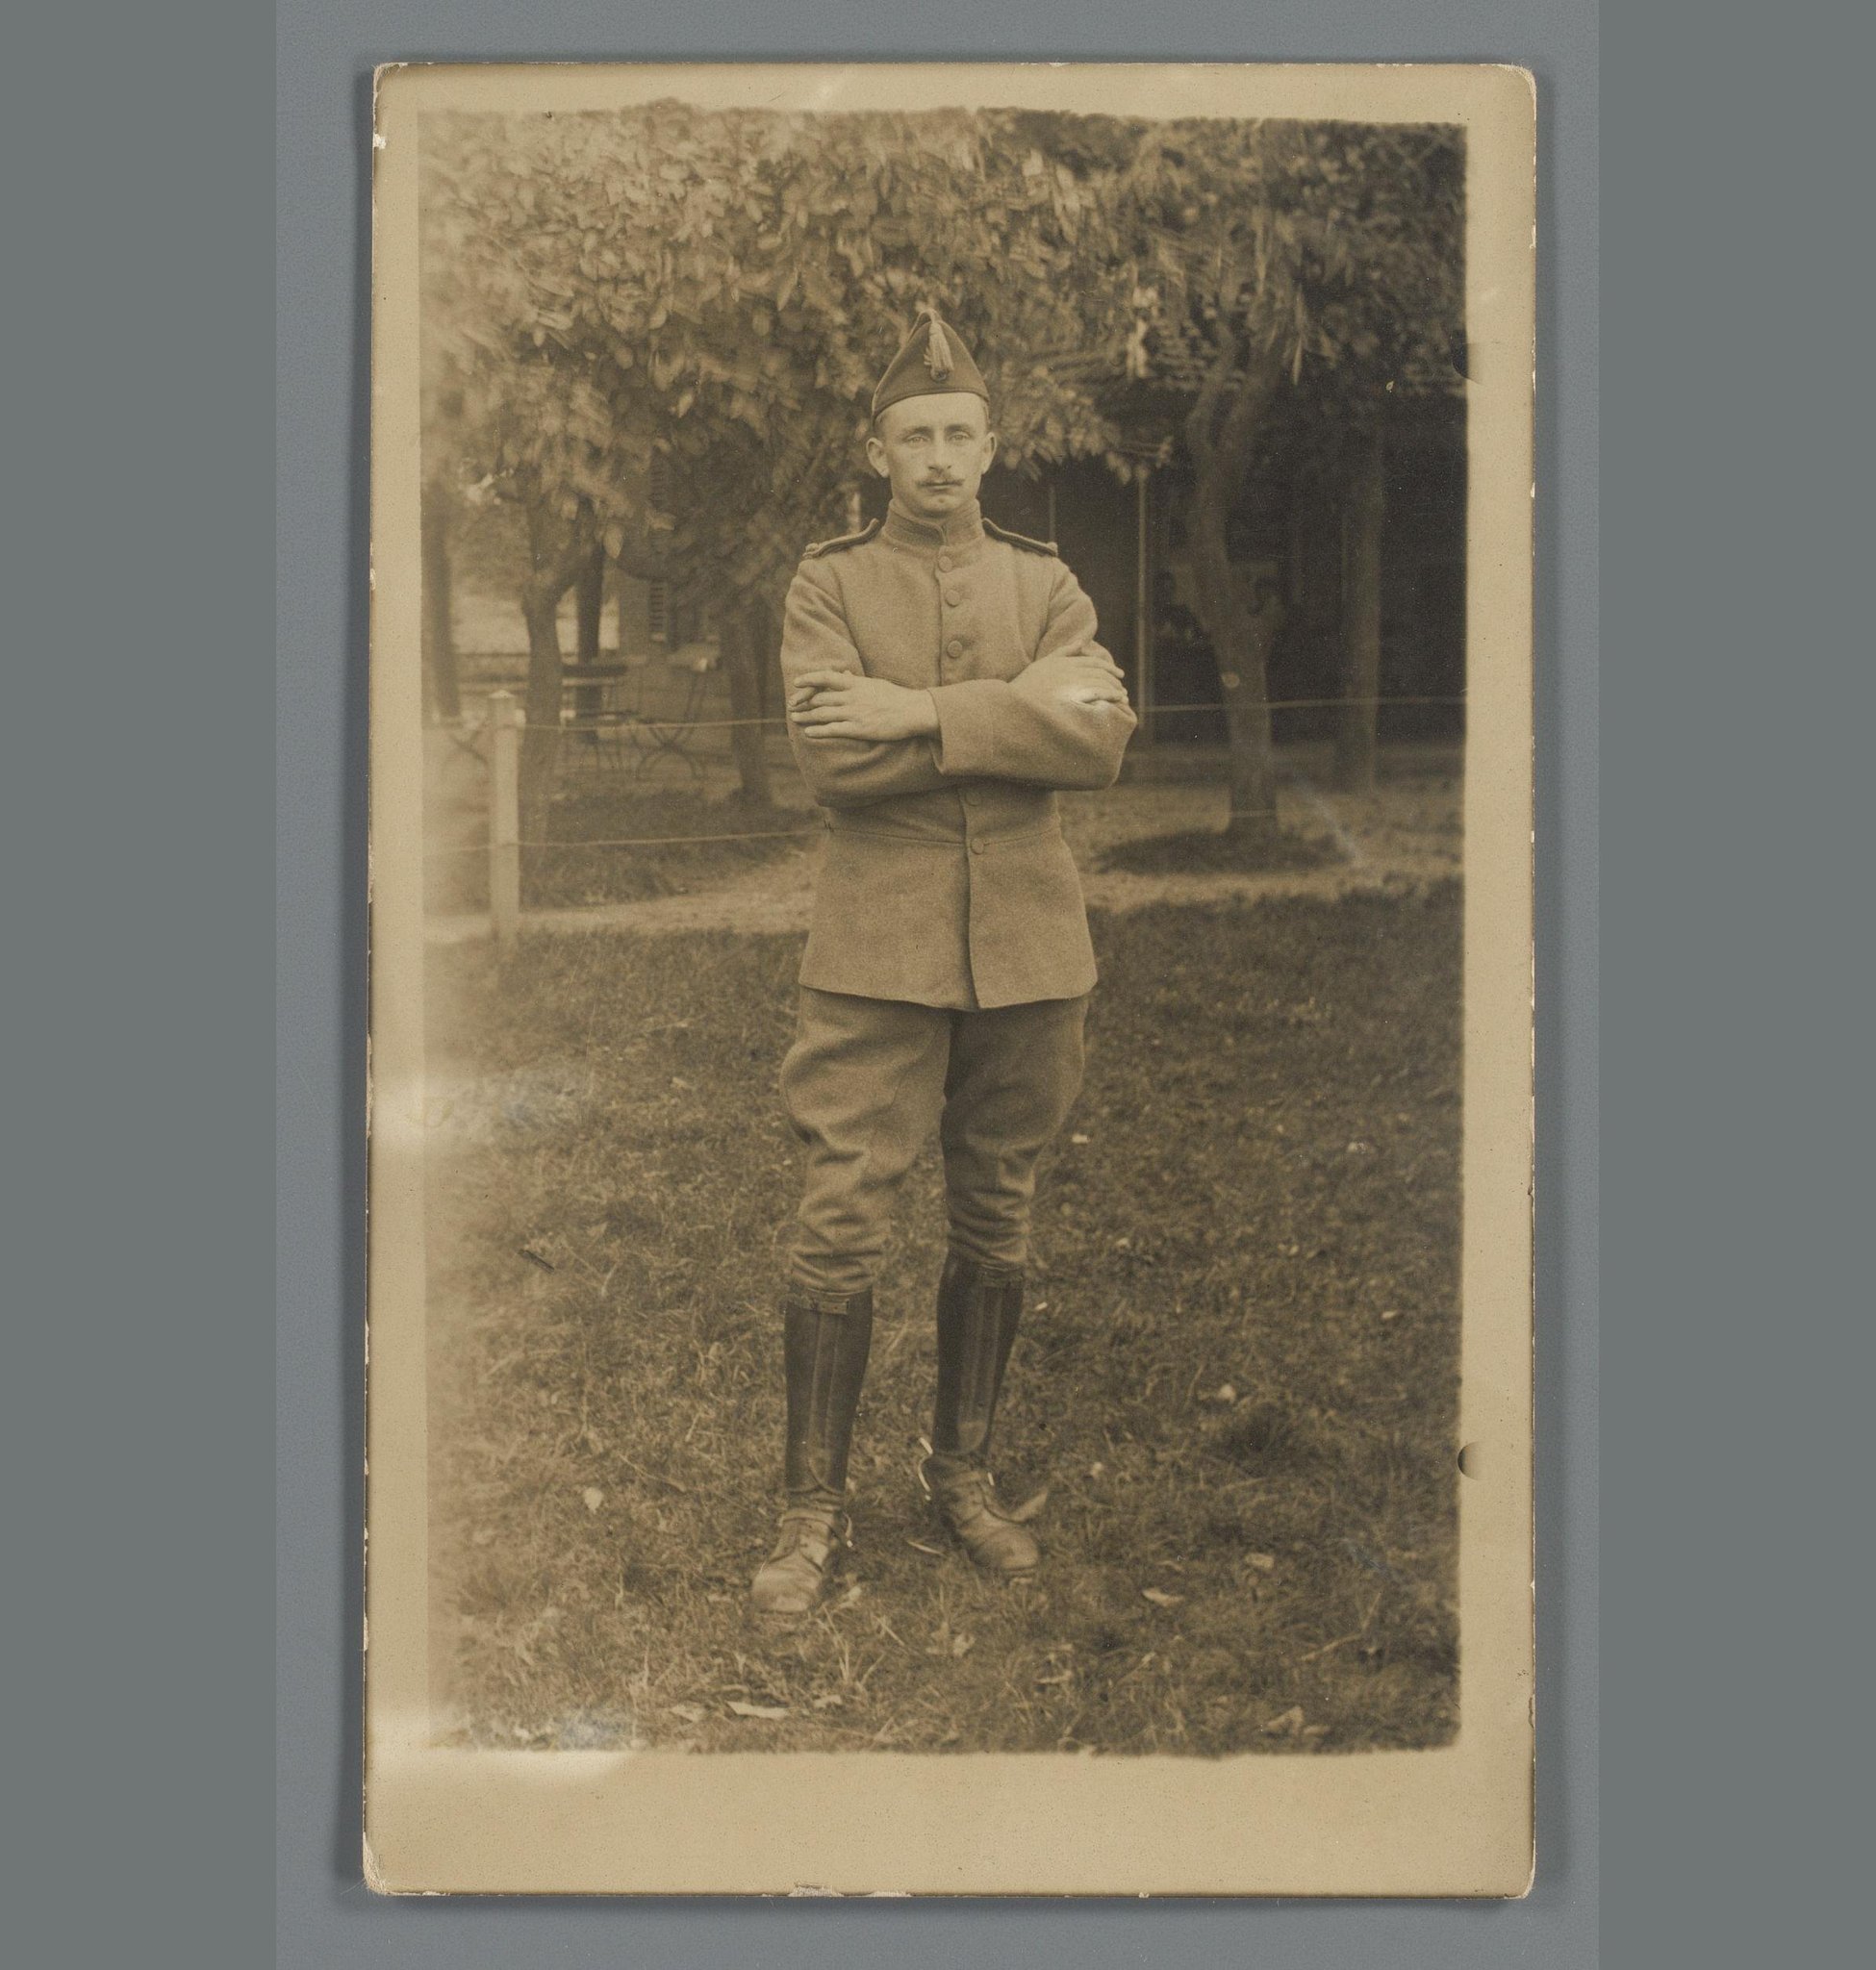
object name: photograph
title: Portret van een onbekende man in militair uniform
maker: Anonymous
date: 1905-1920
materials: paper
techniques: gelatin silver print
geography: netherlands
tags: (military) uniforms, historical persons not known by name, netherlands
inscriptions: inscription: ‘D. Peterse/ H. Peterse Stellinfa/ Straat No18C/ Amersfoort’